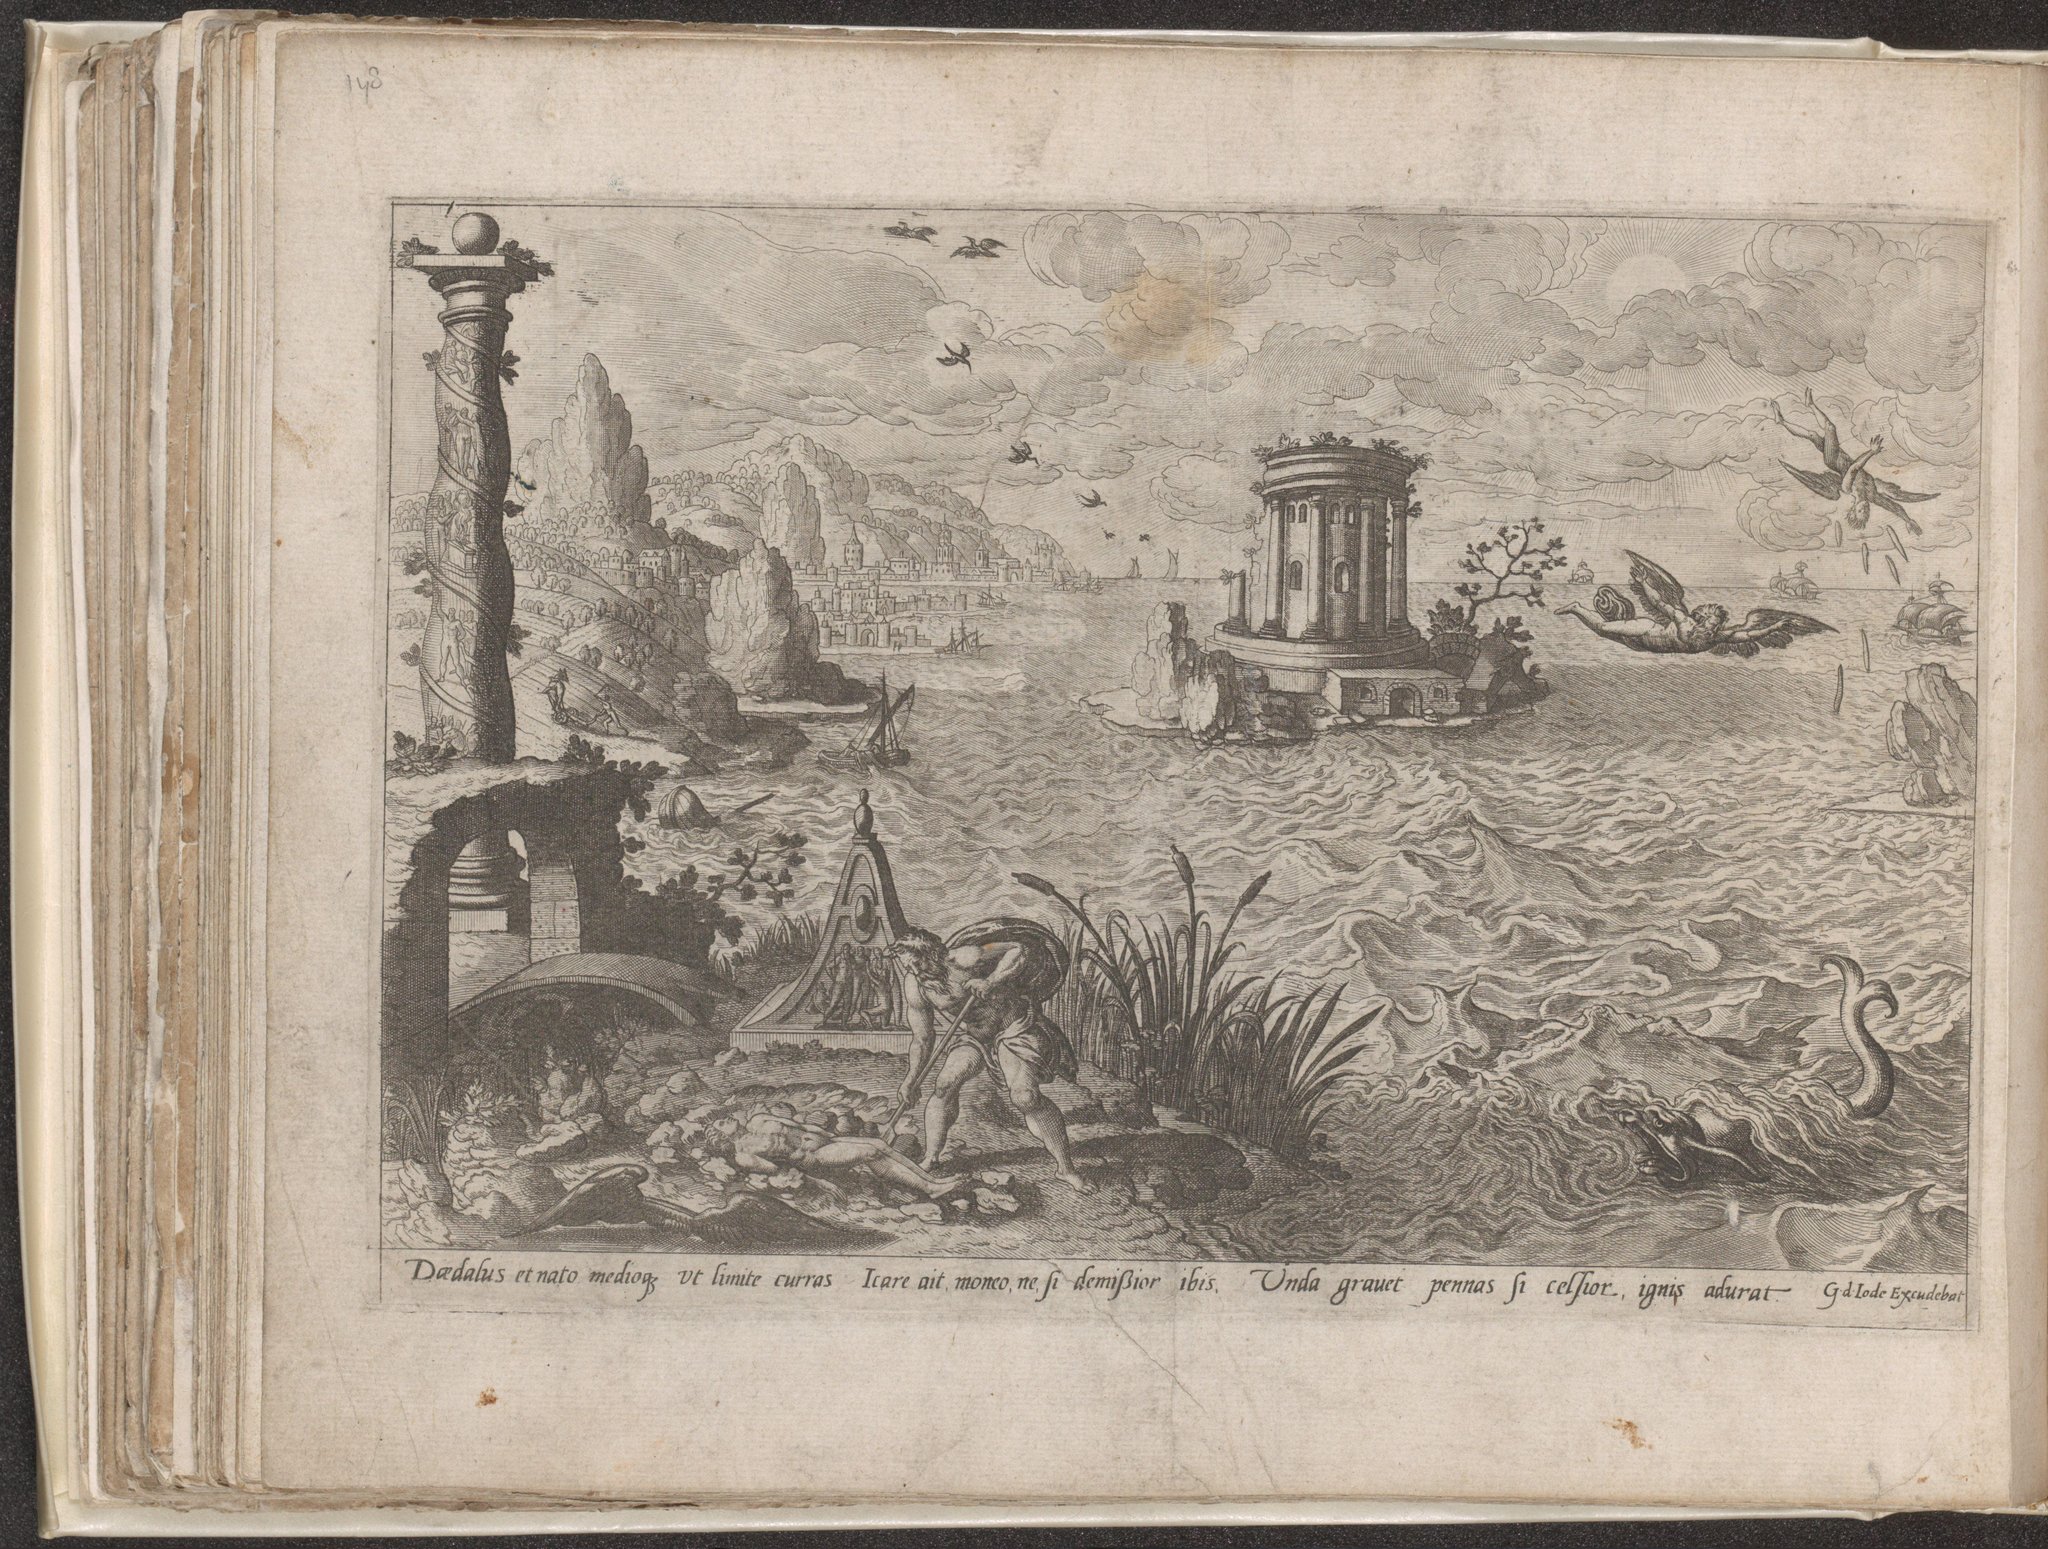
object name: print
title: Daedalus en Icarus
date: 1570-1574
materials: paper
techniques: etching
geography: antwerp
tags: death i.e. the fall of icarus (daedalus present), the flight of daedalus and icarus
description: Daedalus en Icarus, vader en zoon, ontsnappen van het eiland Kreta met vleugels die met was aan hun schouders zijn vastgezet waardoor ze kunnen vliegen. Icarus vliegt echter te hoog waardoor de zon de was doet smelten. Rechts de val van Icarus. In zee zwemt een zeemonster. Links op de voorgrond begraaft Daedalus zijn zoon Icarus. Onder de voorstelling een verklarende tekst in het Latijn. Deze prent maakt deel uit van een album.